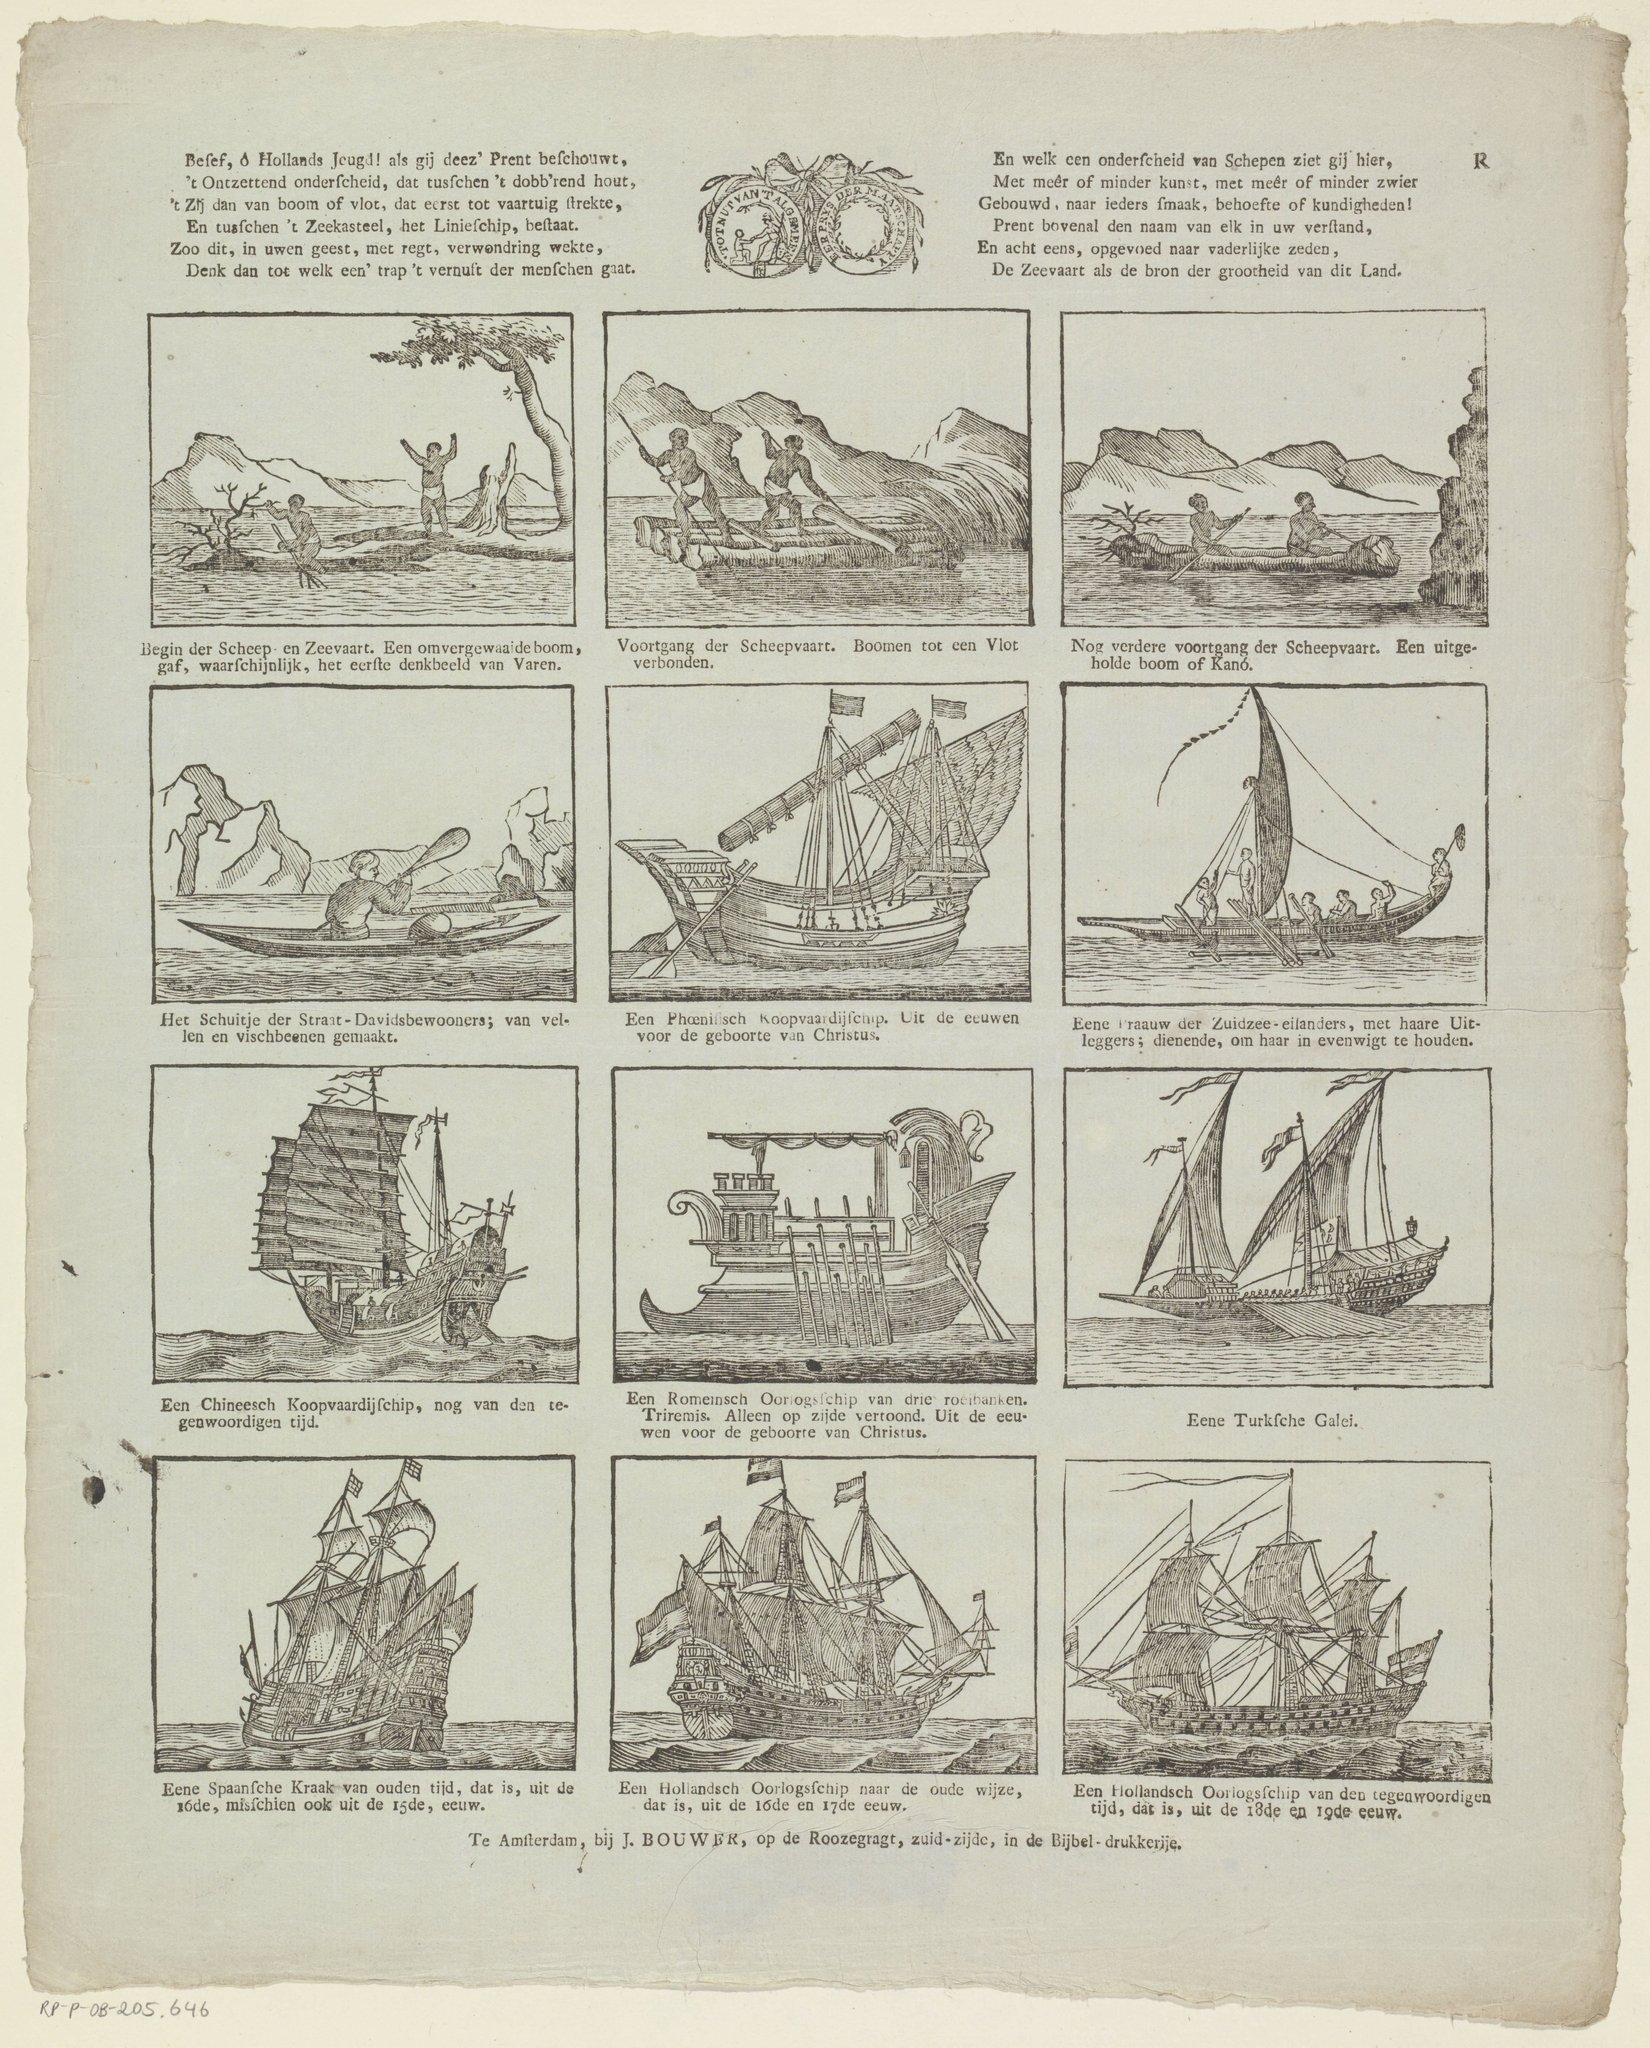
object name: print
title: Besef, ô Hollands jeugd! als gij deez' prent beschouwt, / 't Ontzettend onderscheid, dat tusschen 't dobb'rend hout [(...)]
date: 1805-1808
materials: paper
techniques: letterpress printing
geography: amsterdam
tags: traffic on the water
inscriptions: collector's mark: Lugt 2760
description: Blad met 12 voorstellingen van vaartuigen, zoals een simpele boomstamkano en een Hollands oorlogsschip. Bovenaan twee zesregelige verzen. Midden boven het zegel van de Maatschappij tot Nut van 't Algemeen. Onder elke afbeelding een tweeregelig onderschrift. Genummerd rechtsboven: R.